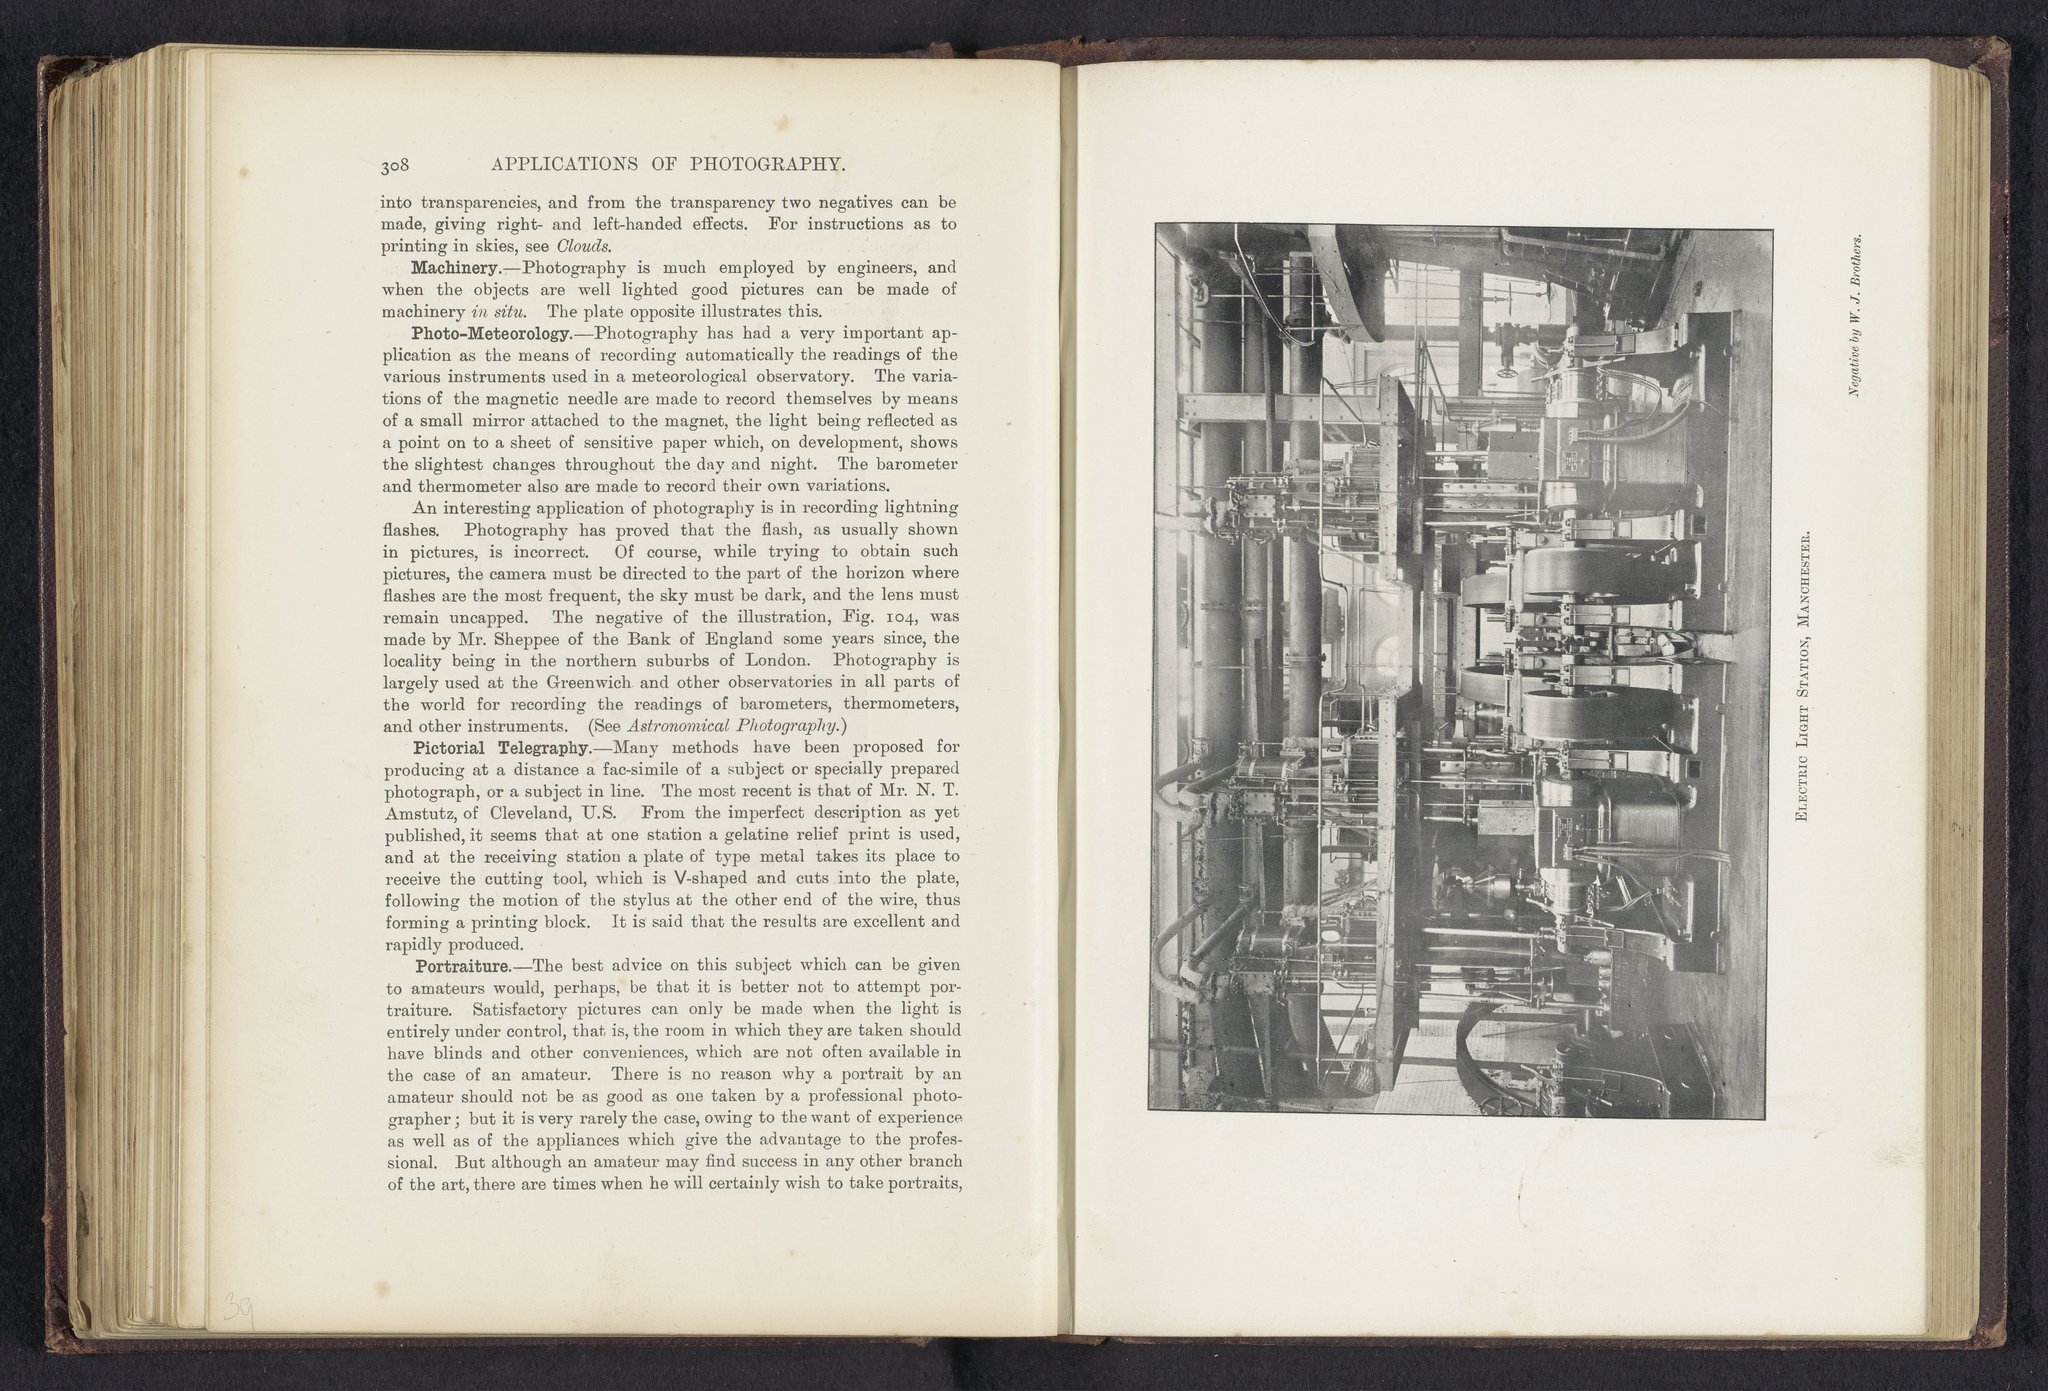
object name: photomechanical print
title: Electric light stations, Manchester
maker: Anonymous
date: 1889-1899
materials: paper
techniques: autotype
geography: manchester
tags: power station, exterior ~ representation of a building